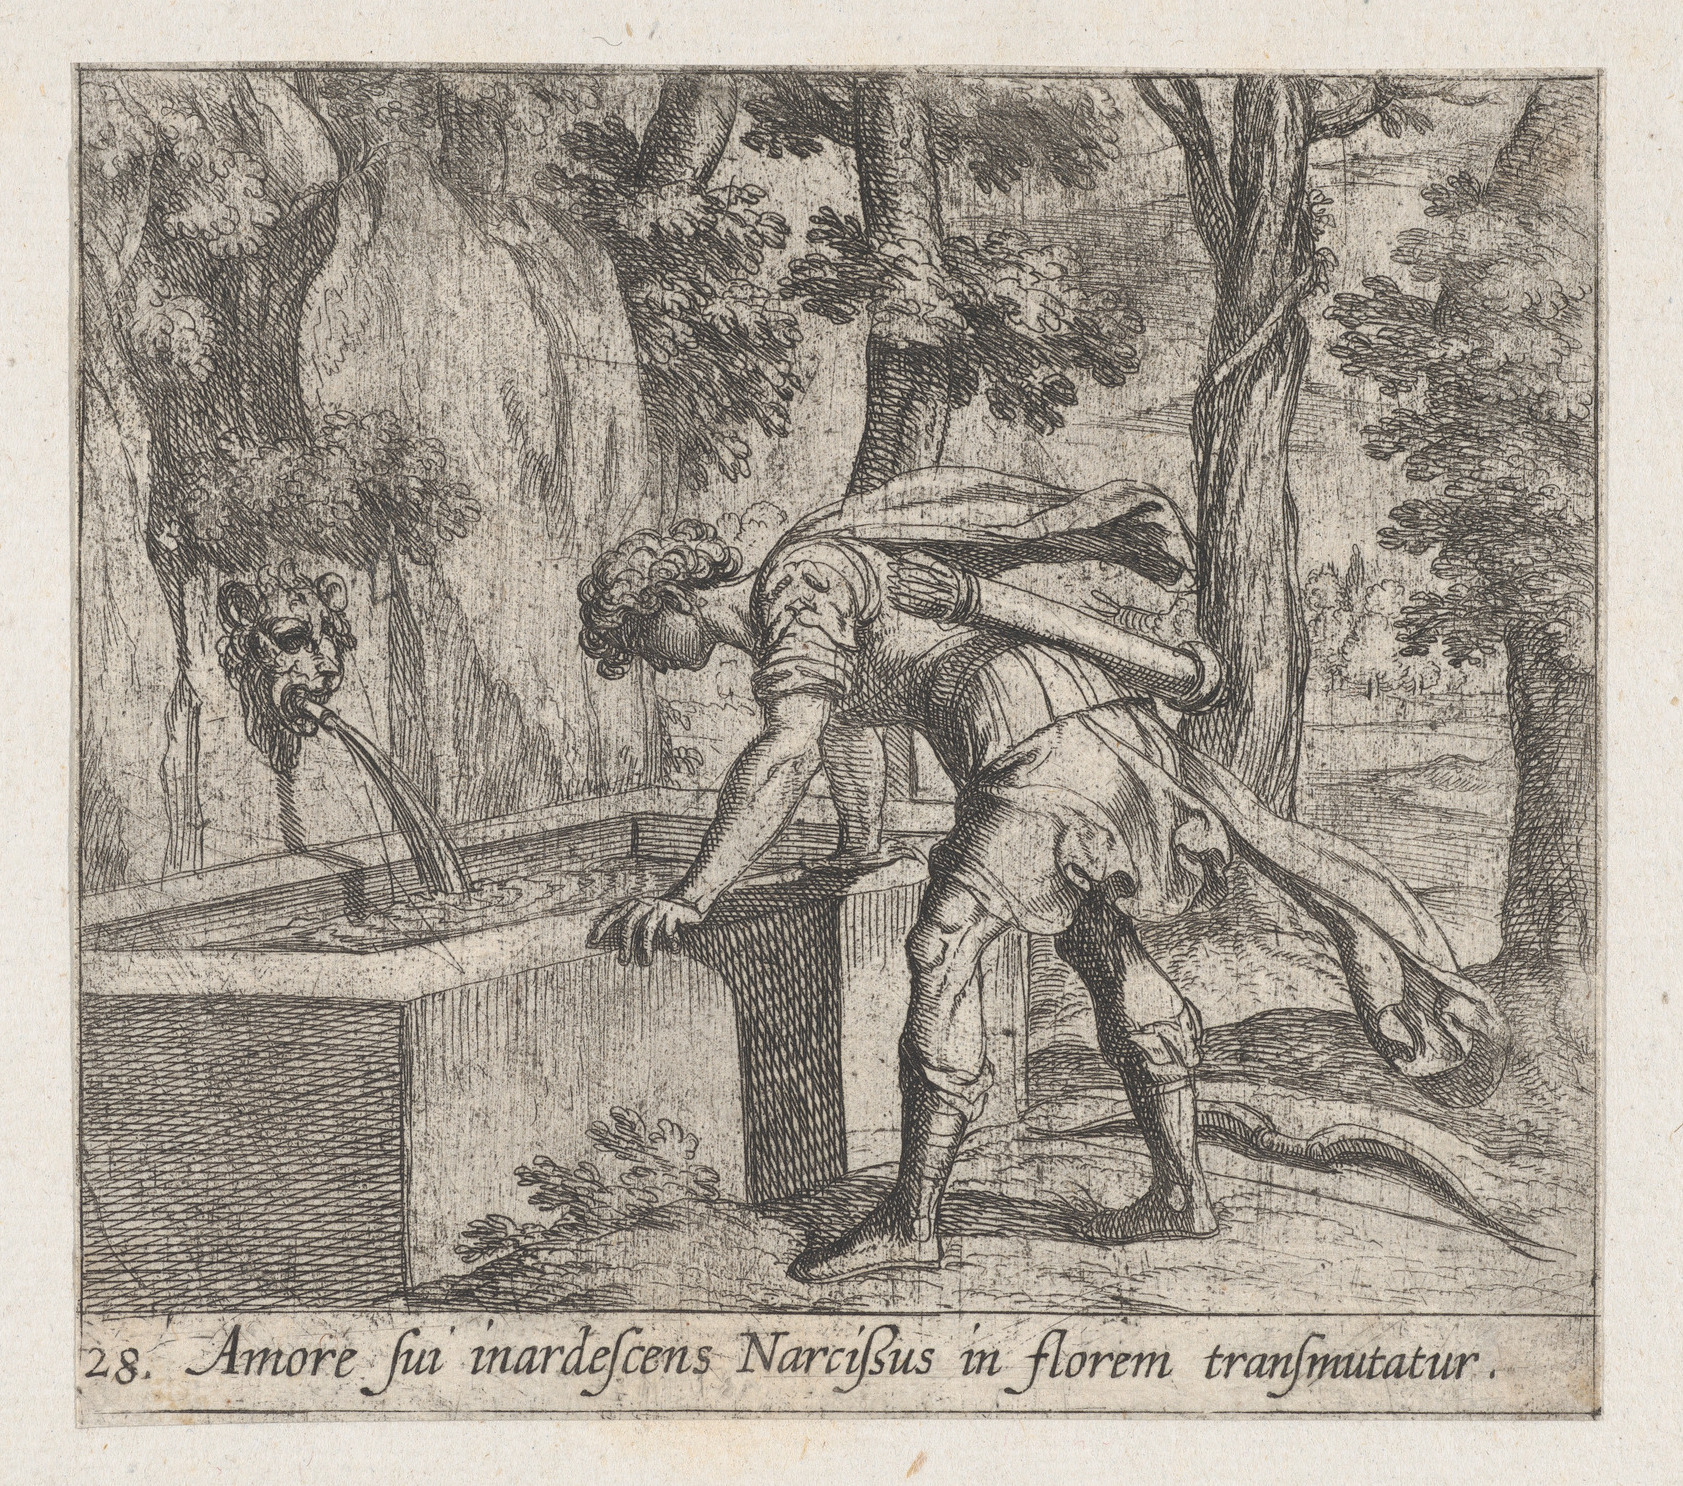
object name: print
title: Plate 28: Narcissus at the Well (Amore fui inardescens Narcißus in florem transmutatur), from Ovid's 'Metamorphoses'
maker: antonio tempesta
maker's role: artist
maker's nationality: italian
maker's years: 1555-1630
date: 1606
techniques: etching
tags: wells,men,narcissus